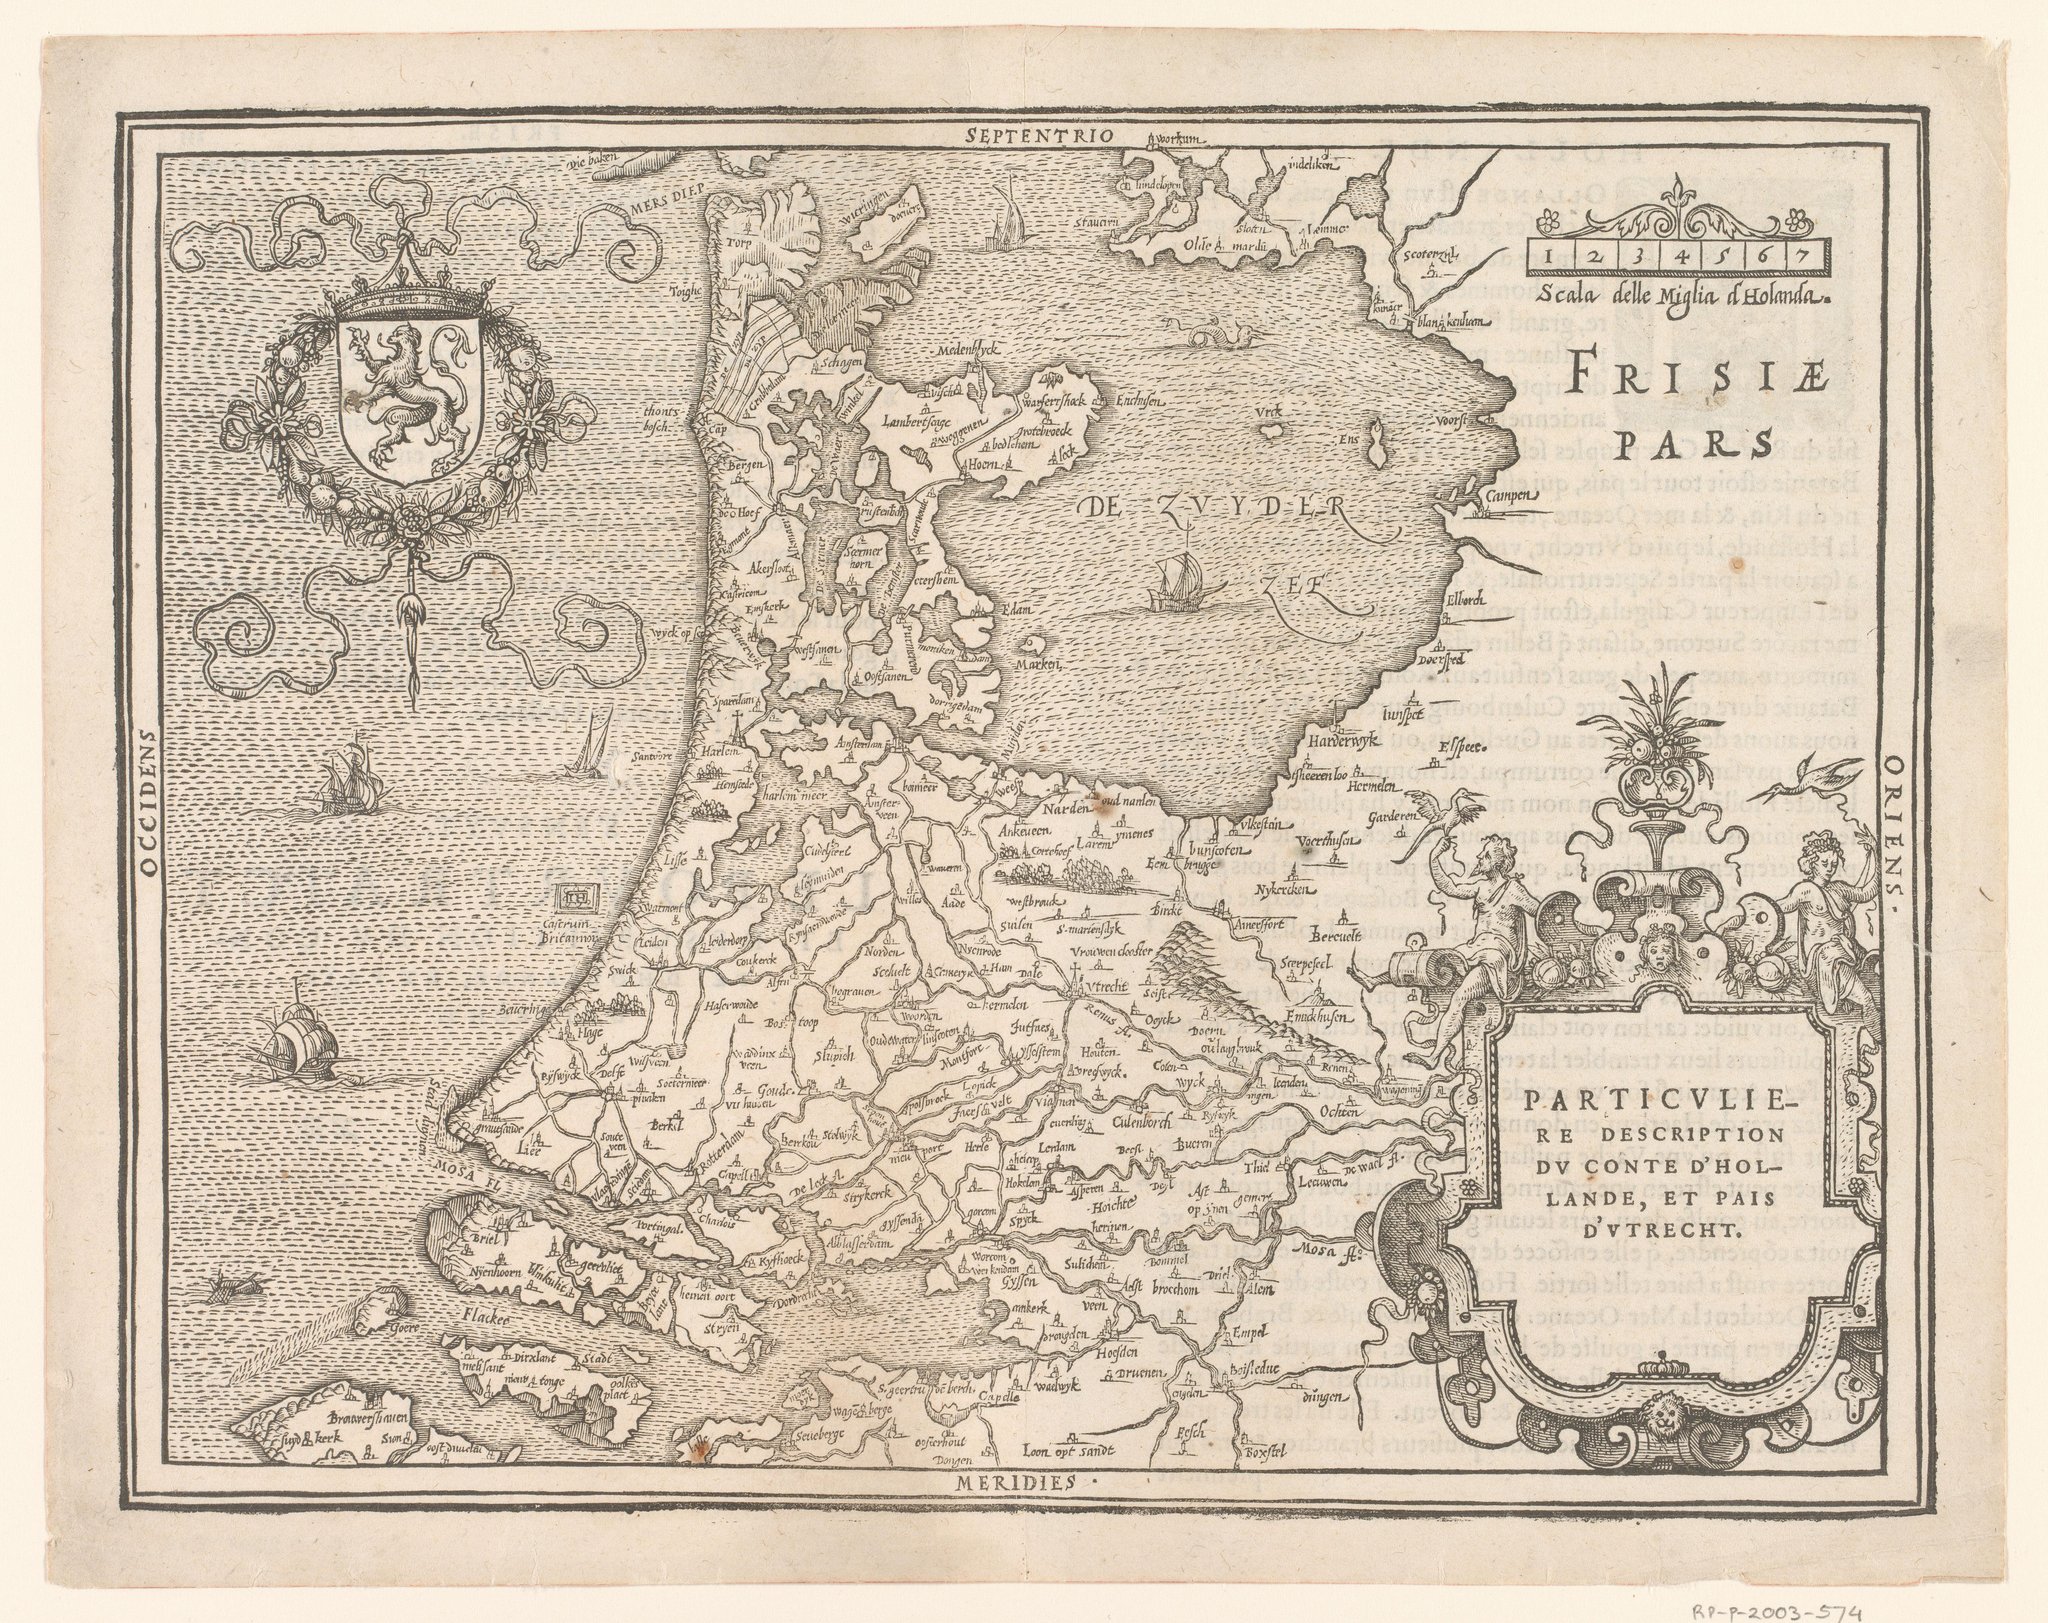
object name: print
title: Particulie- | re description | du Conte d'Hol- | lande, et pais | d'Utrecht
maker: cornelis jansz muller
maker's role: print maker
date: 1567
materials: paper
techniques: letterpress printing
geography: antwerp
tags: maps of separate countries or regions, holland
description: Kaart van het graafschap Holland en de heerlijkheid Utrecht. Rechtsonder een gesneden cartoche met een man en een vrouw met vogels, in de cartouche de gedrukte Franse titel. Linksboven het wapen van Holland. Rechtsboven een schaalstok. Bedrukt op de achterzijde met twee bladzijden (p. 238 en 235) tekst in boekdruk in het Frans. Boekdruk verso rechts: S'Ensuyt le Pourtraict et Description du Conté d'Hollande, et Païs d'Utrecht / Z iij. Onderdeel van de verzameling kaarten genomen uit een latere editie van: Descrittione di tutti i Paesi Bassi van Lodovico Guicciardini.